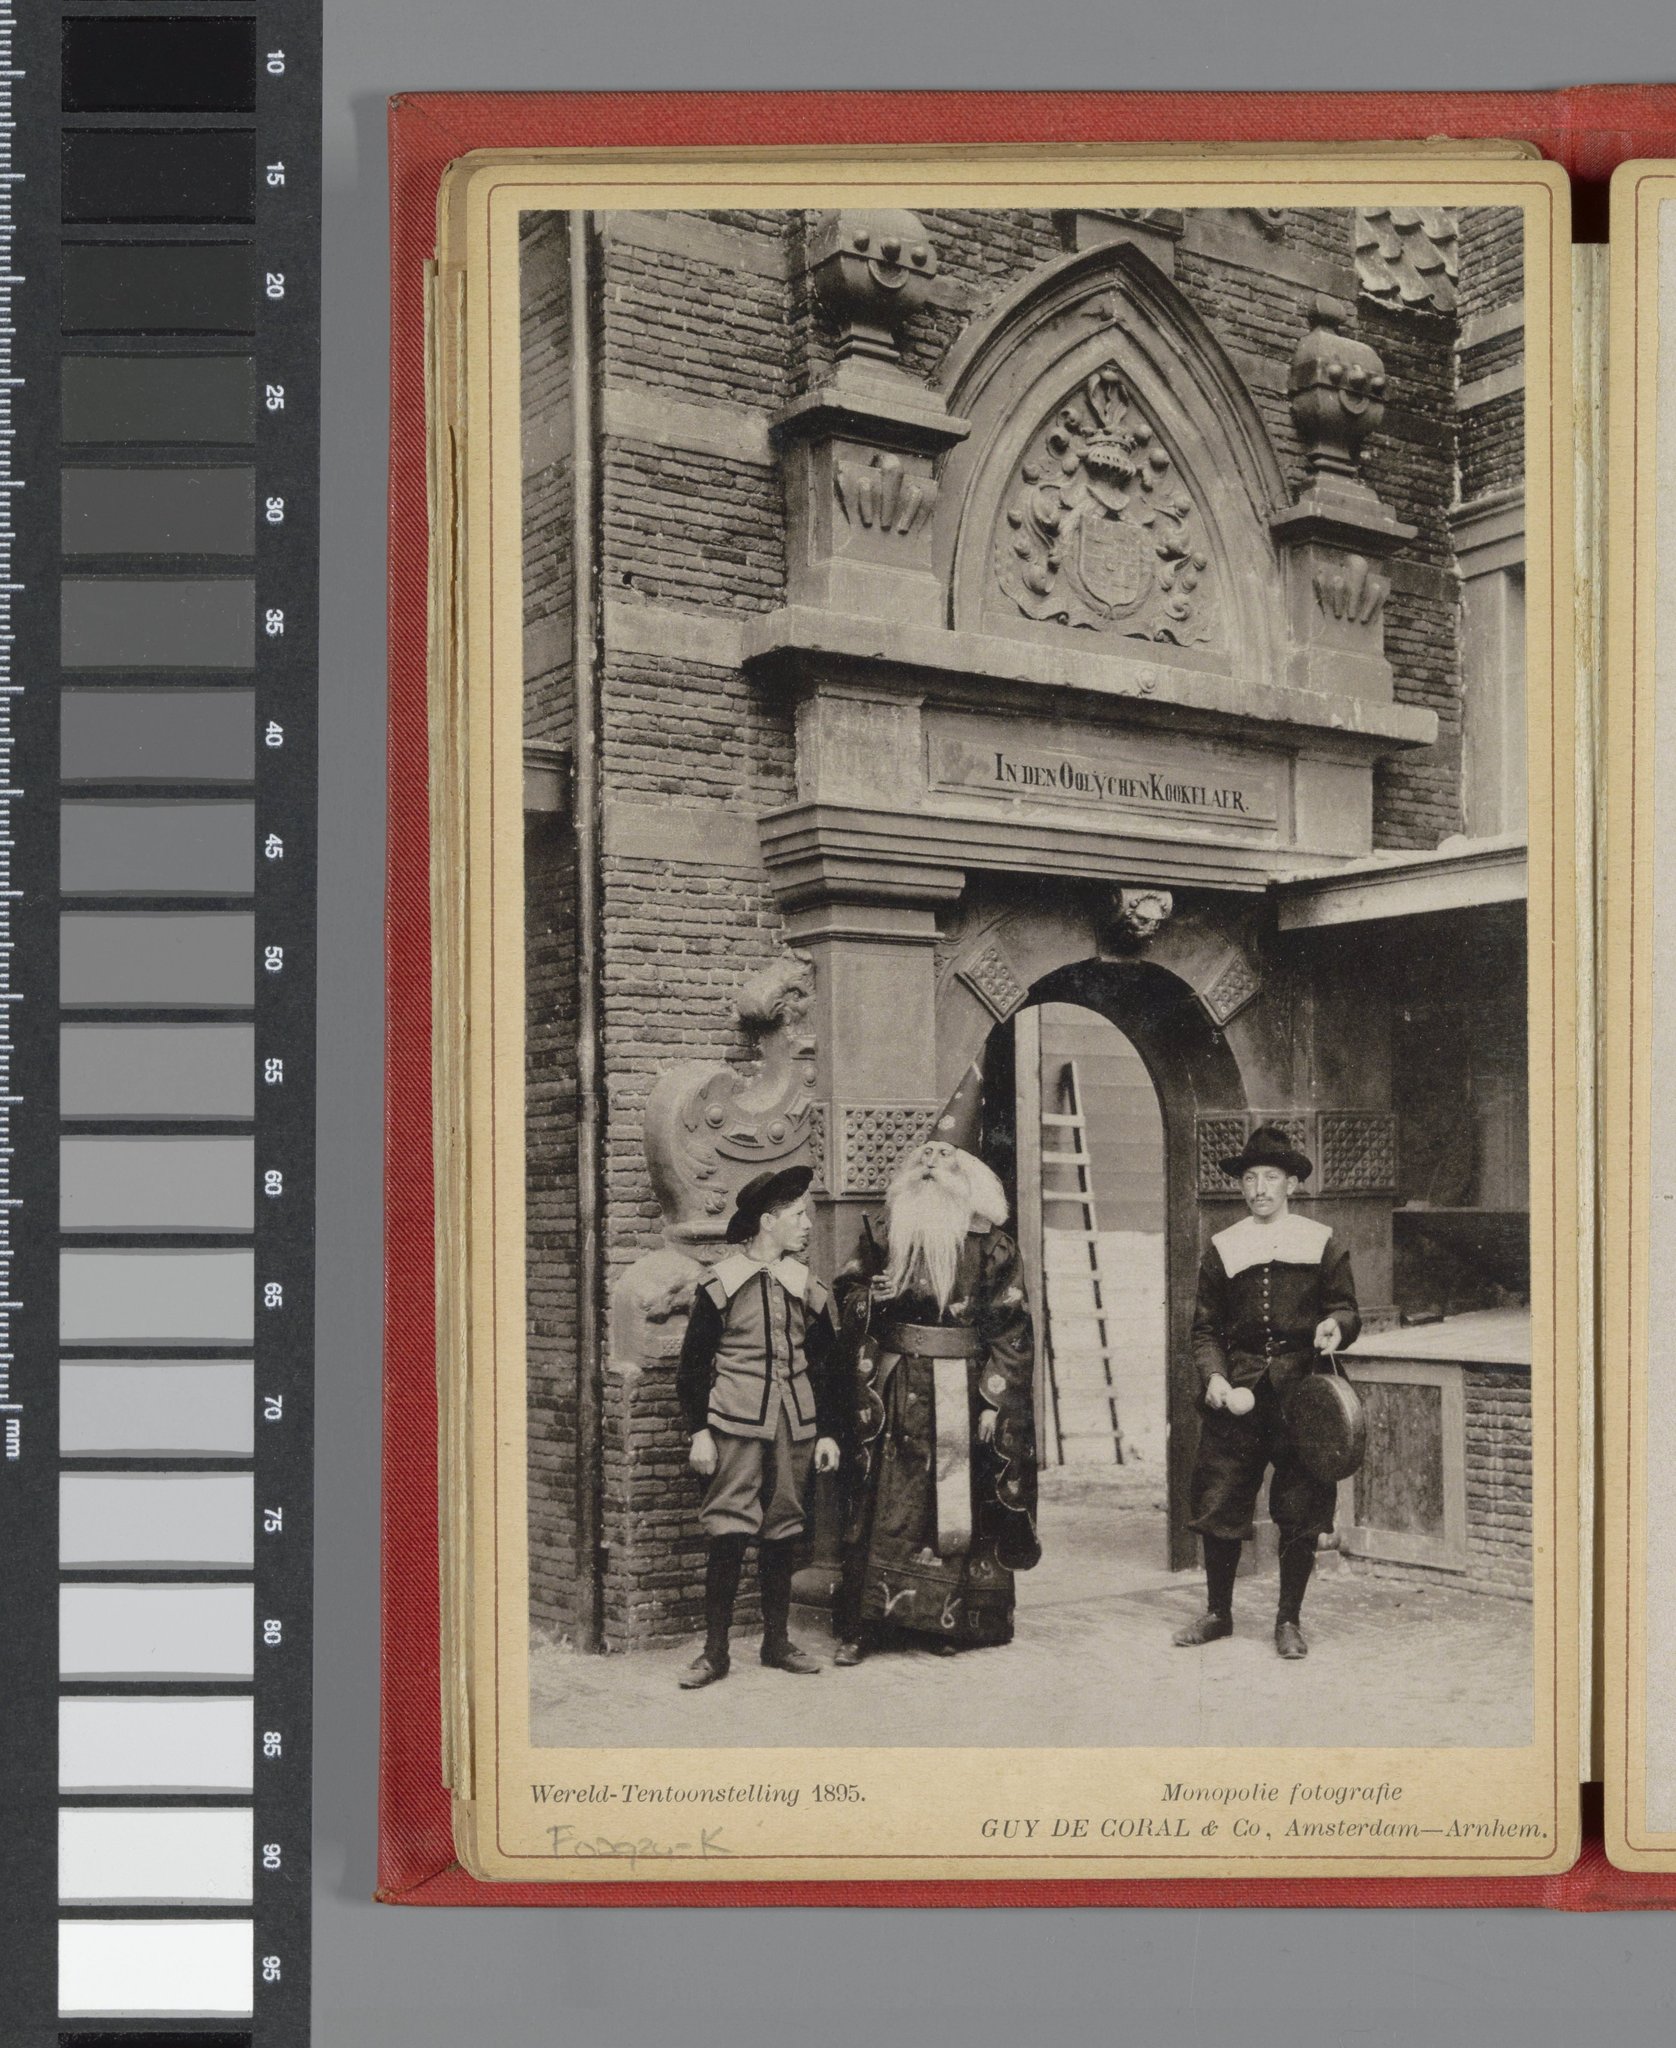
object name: cabinet photograph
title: Wereld-Tentoonstelling 1895.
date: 1895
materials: cardboard, paper, ink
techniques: photograph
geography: amsterdam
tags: sorcerer, magician, wizard, warlock, historical costume, gate, entrance, prospect of city, town panorama, silhouette of city, temporary exhibition, 'salon', amsterdam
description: Onderdeel van Fotoalbum met opnames van de Wereldtentoonstelling voor het Hotel- en Reiswezen op het Museumplein in 1895.